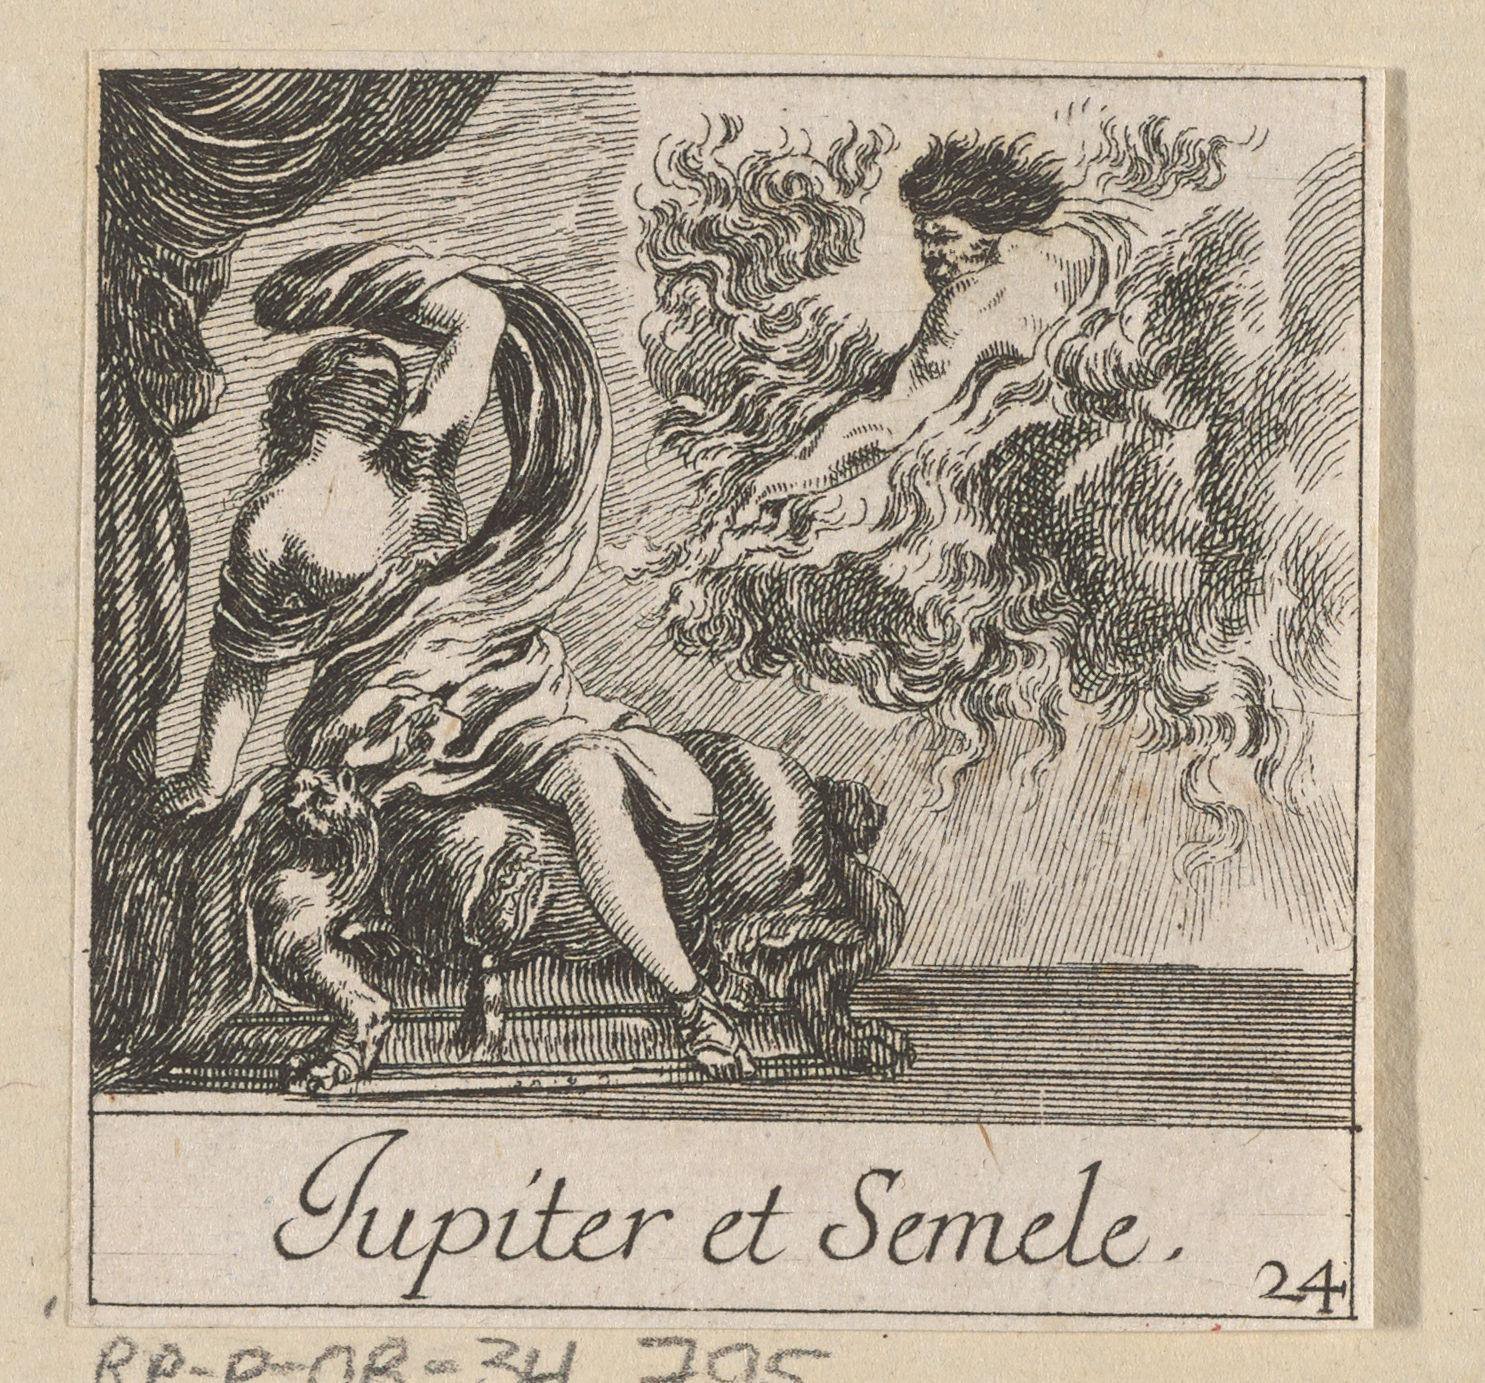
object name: playing card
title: Kaartspel met mythologische voorstellingen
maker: Anonymous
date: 1620-1664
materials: paper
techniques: etching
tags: jupiter wooing semele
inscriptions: collector's mark: Lugt 240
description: Prent uit een reeks van 54 genummerde speelkaarten met voorstellingen uit de Metamorfosen van Ovidius.